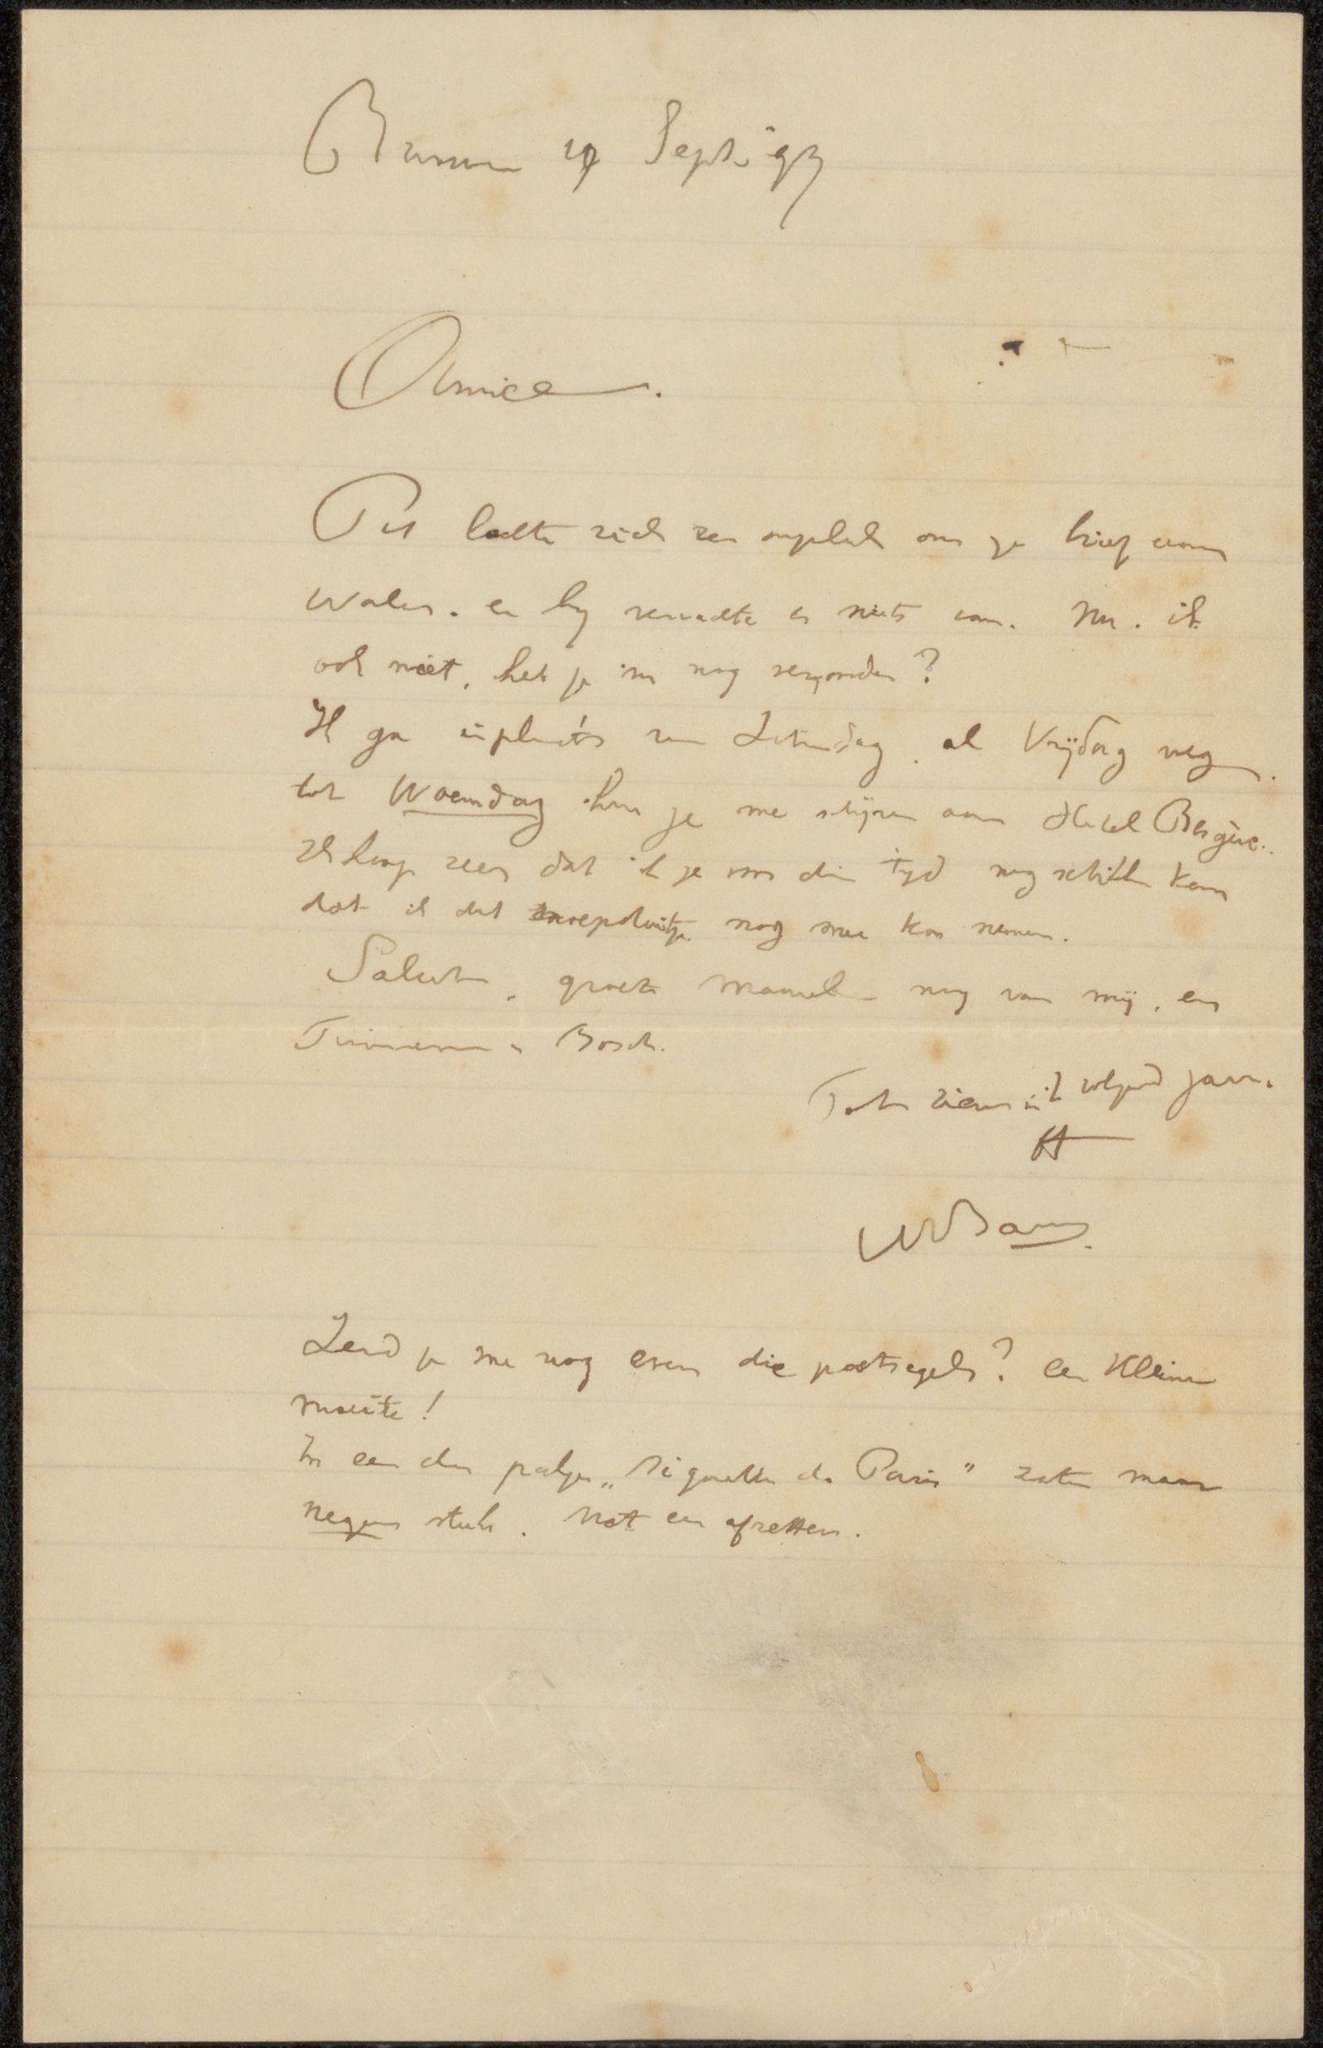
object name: letter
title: Brief aan Philip Zilcken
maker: marius bauer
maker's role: draughtsman, print maker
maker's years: 1867-1932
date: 1897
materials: ink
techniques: pen, writing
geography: bussum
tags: marinus van der maarel, etienne bosch, nijmegen, adriaan pit, philip zilcken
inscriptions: collector's mark: ‘RPK’